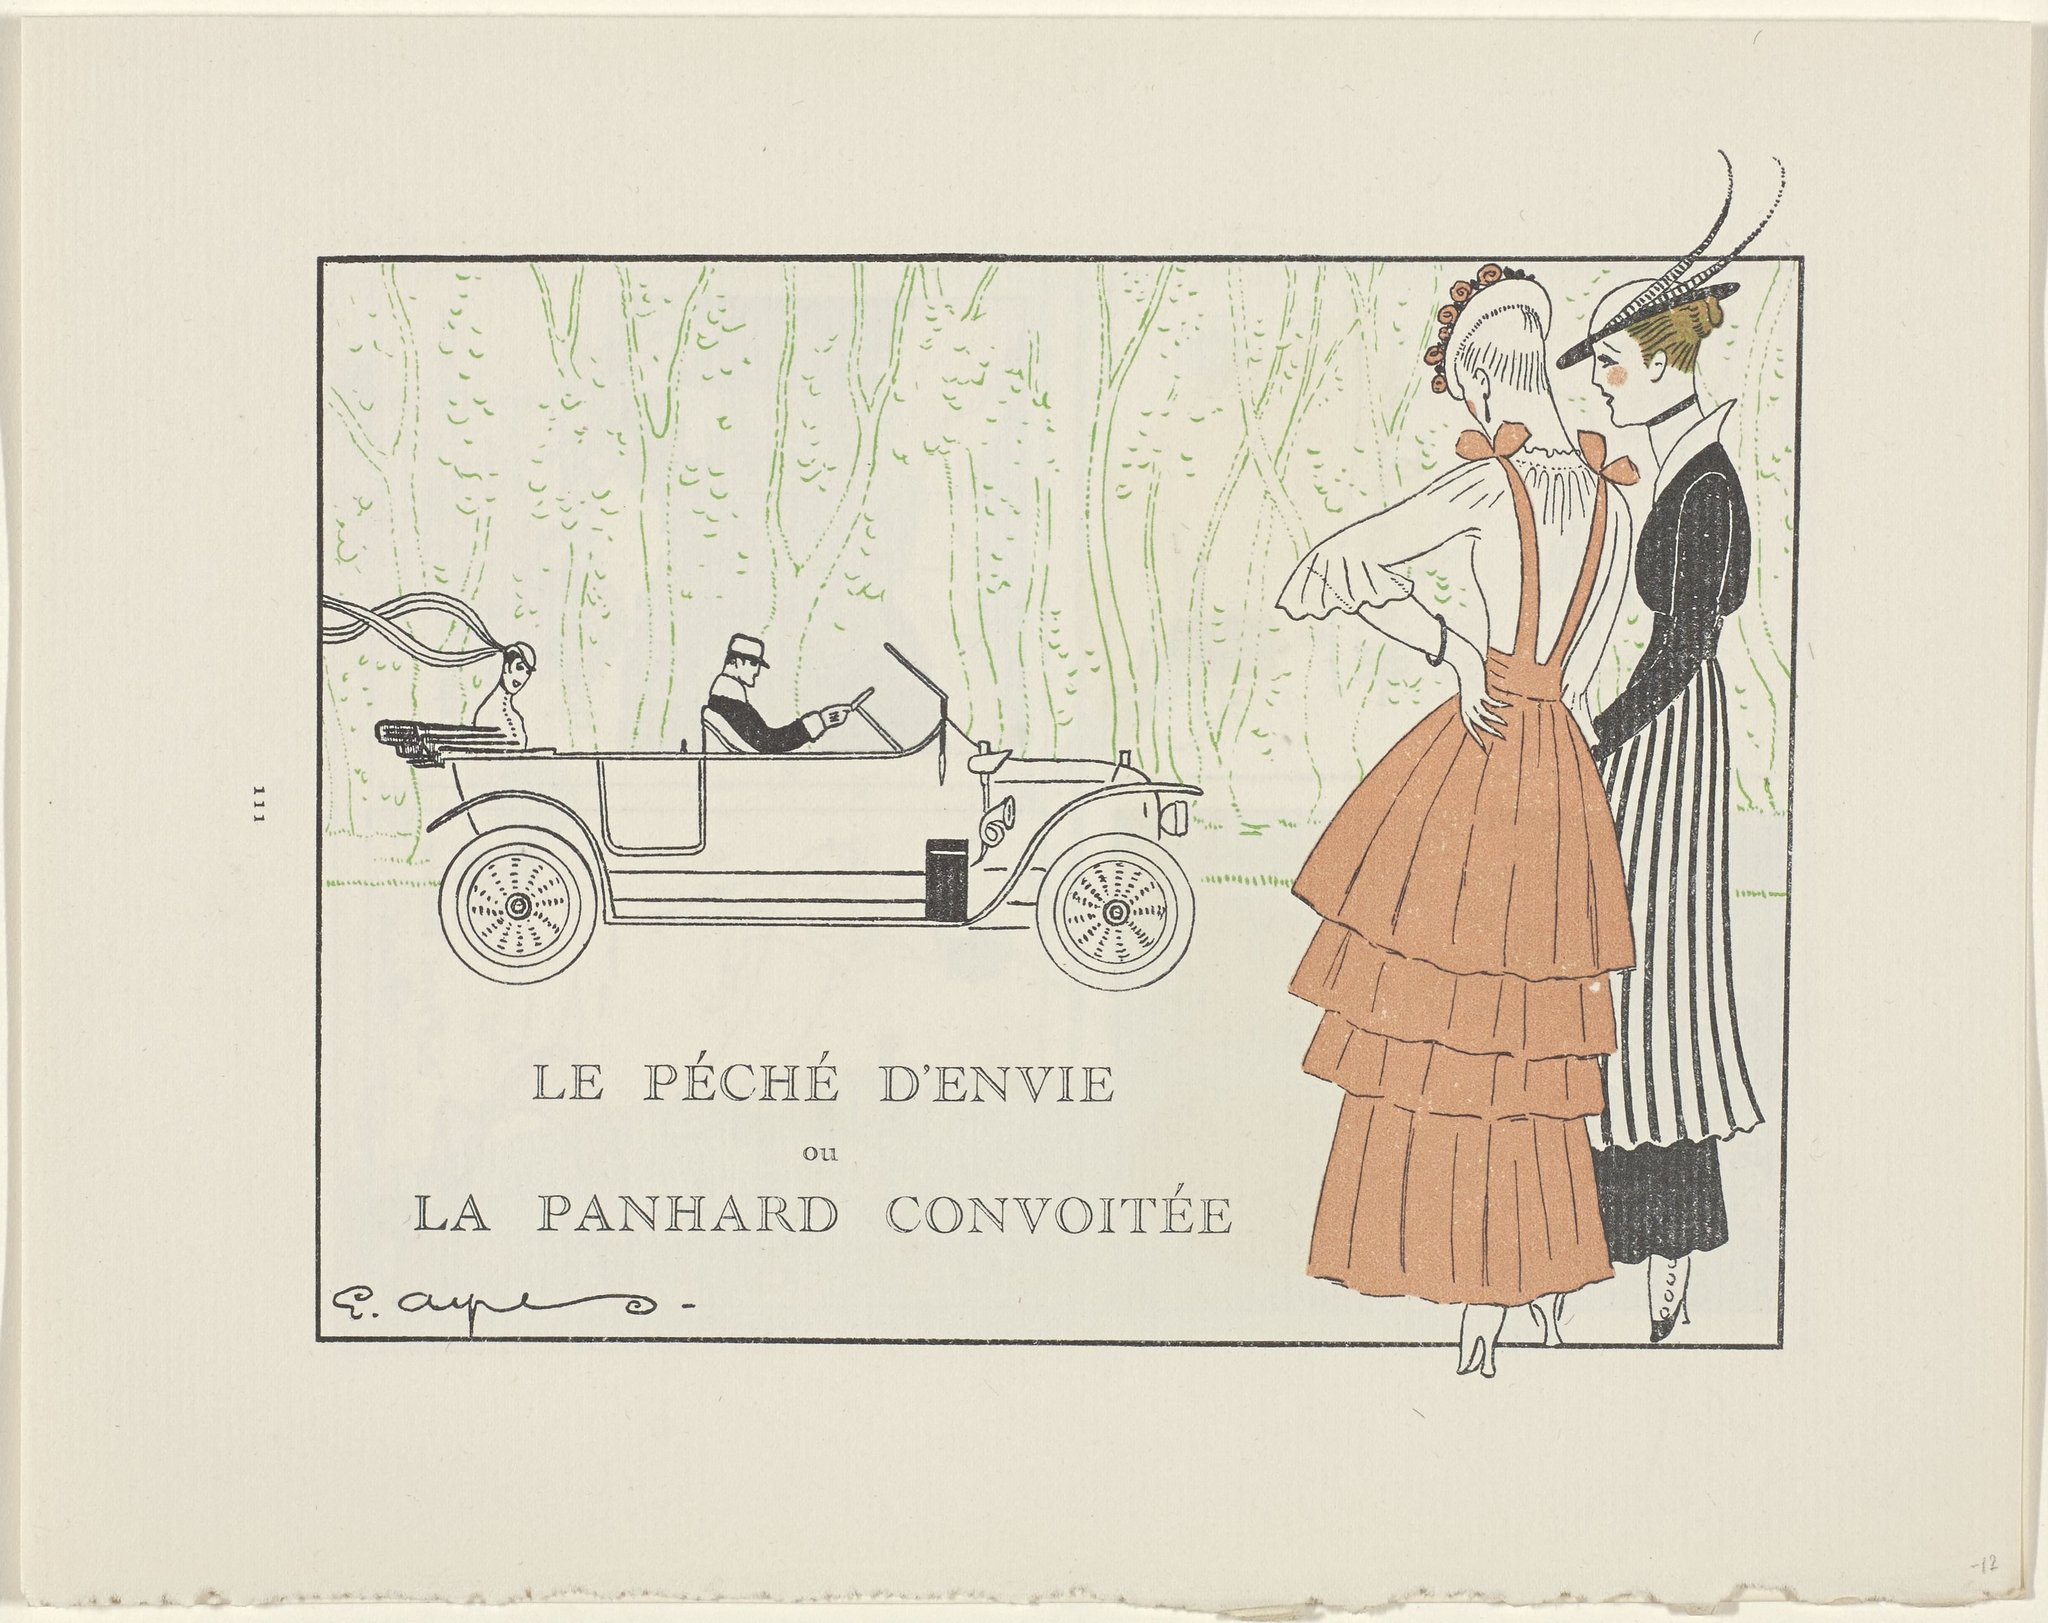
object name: fashion print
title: Gazette du Bon Ton, 1914 - No. 7, Le Péché d'Envie ou La Panhard Convoitée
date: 1914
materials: paper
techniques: hand coloring, letterpress printing, lithograph, pochoir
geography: berlin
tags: park, fashion plates, dress, gown (+ women's clothes)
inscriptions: date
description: Advertentie Panhard: Le Péché d'Envie ou La Panhard Convoitée: twee vrouwen kijken afgunstig naar een voorbijrijdende Panhard. Uit Gazette du Bon Ton 1914, No. 7, p. III